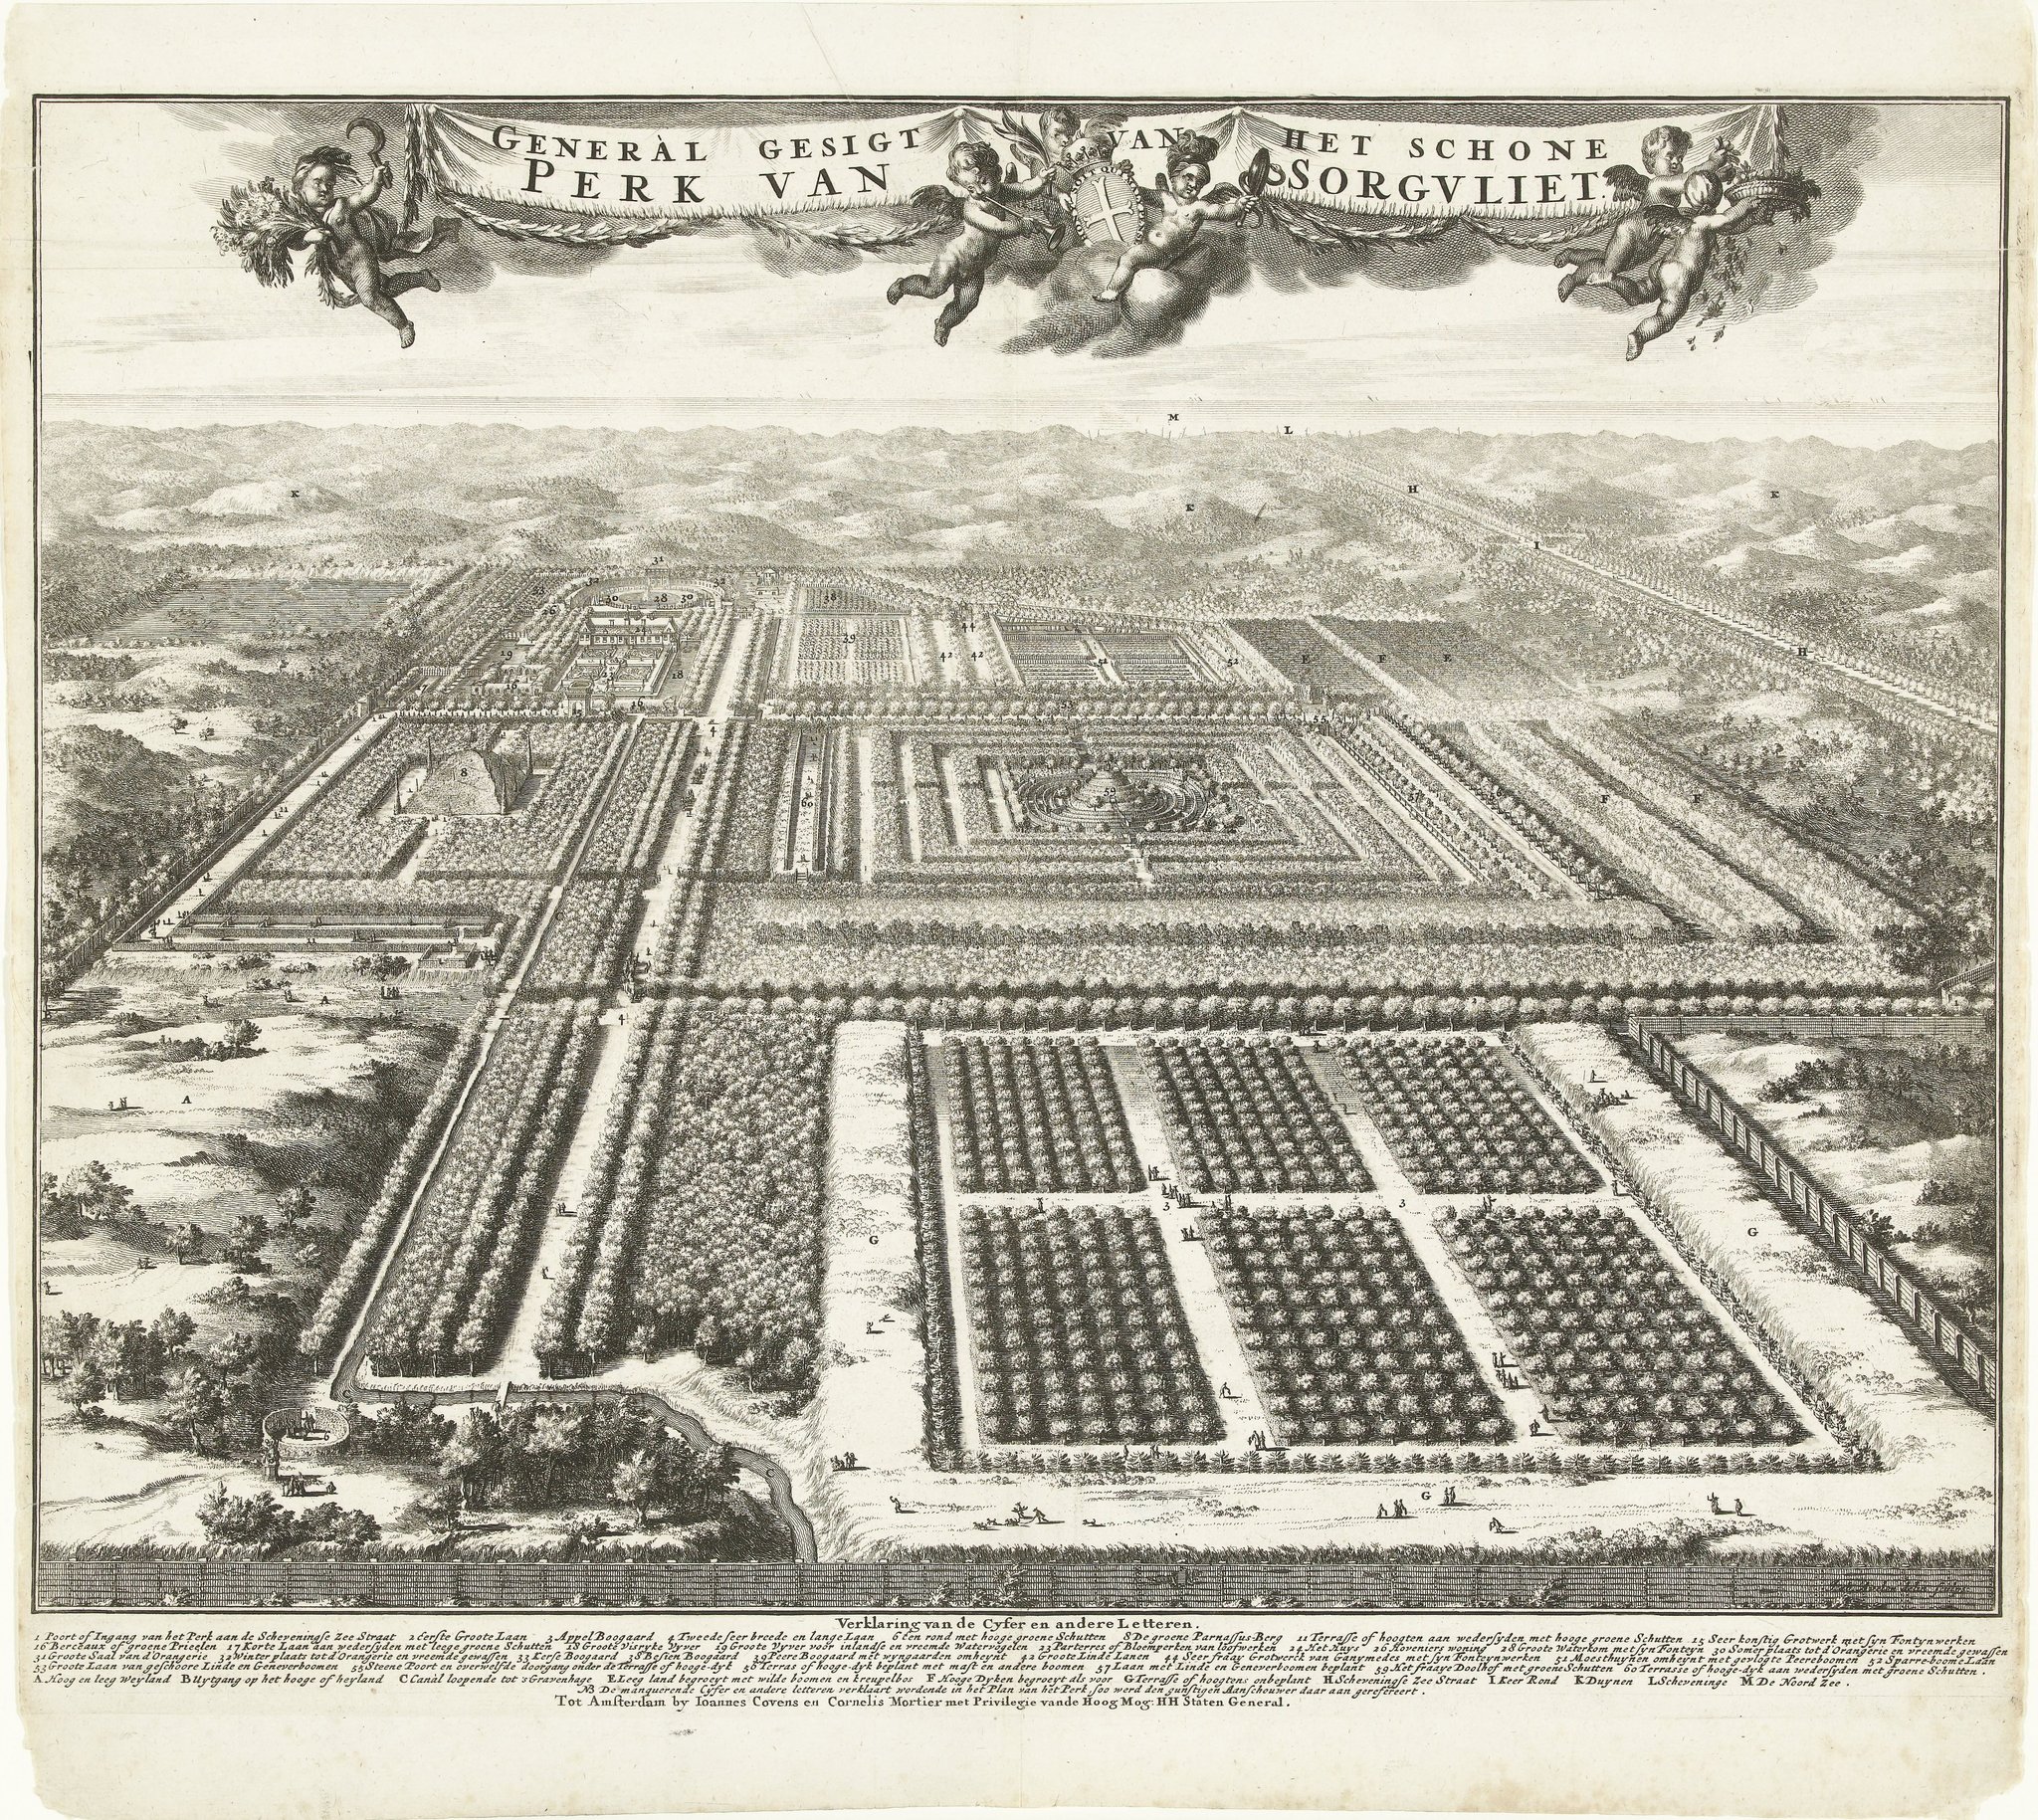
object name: print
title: Generàl gesigt van het schone Perk van Sorgvliet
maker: johannes jacobsz van den aveele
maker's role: print maker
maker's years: 1655-1727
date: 1721-1774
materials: paper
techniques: engraving, etching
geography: northern netherlands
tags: park, dune coast, plan, map of garden, french or architectonic garden; formal garden, labyrinth, maze ~ garden, the hague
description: Vogelvluchtaanzicht van het landgoed Zorgvliet te Den Haag. Op de achtergrond de duinen en de zee, rechts de badplaats Scheveningen (L). In het park zijn de oranjerie (31), het Catshuis (24), de Parnassusberg (8) en het doolhof (59) goed te herkennen. Met een legenda van 1-60 en A-M.